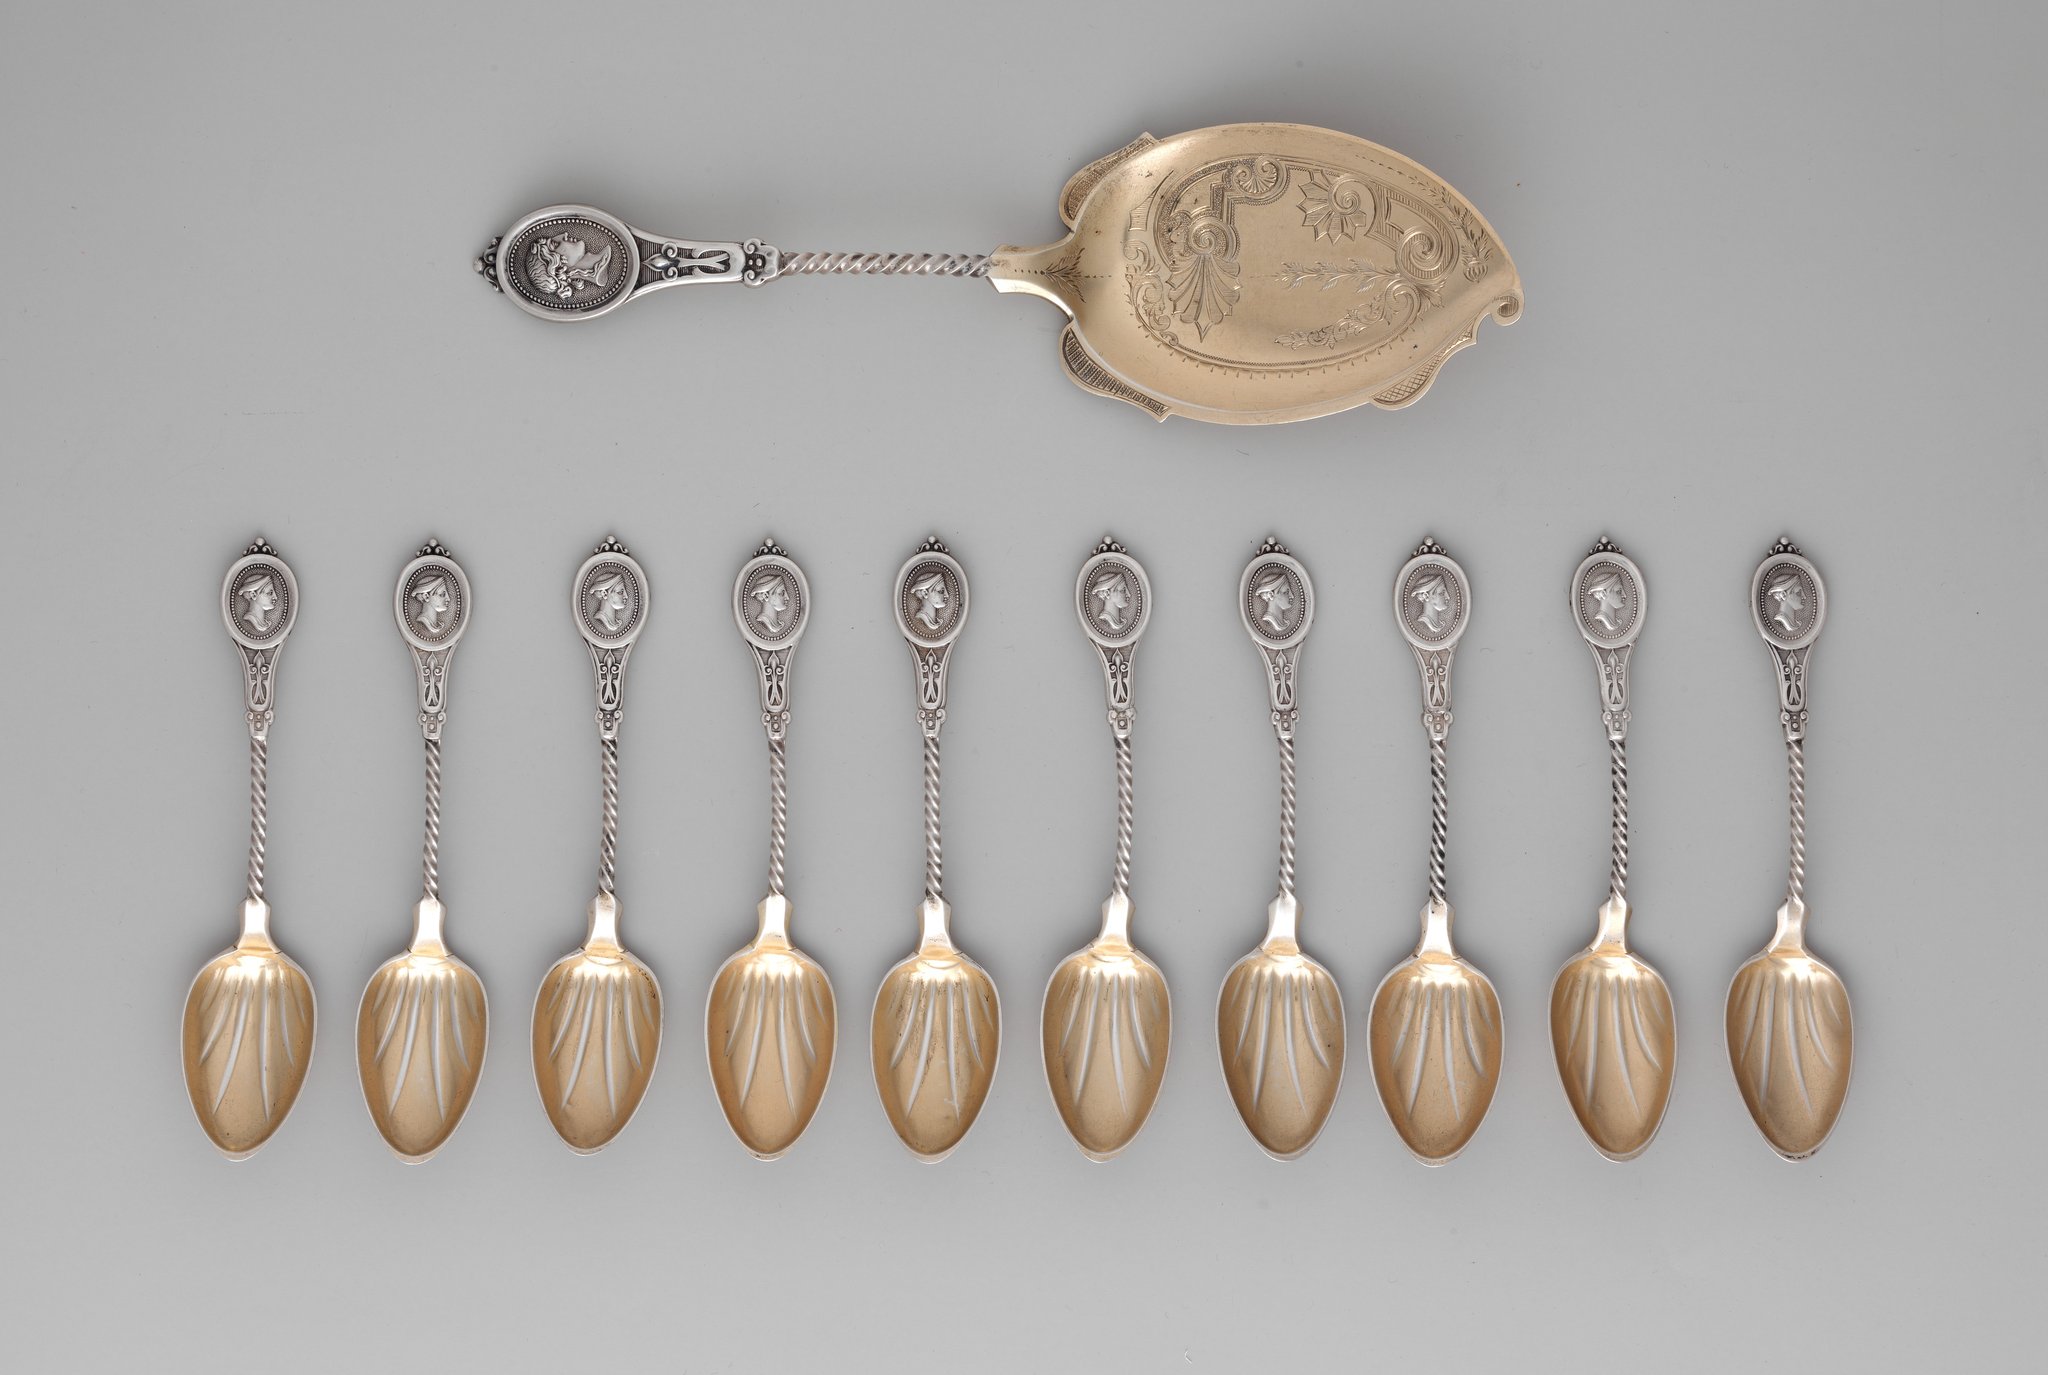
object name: ice cream slicer and spoon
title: Ice Cream Slicer and 10 Ice Cream Spoons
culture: american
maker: kidney, cann & johnson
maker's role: maker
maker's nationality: american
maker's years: 1863-1867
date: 1863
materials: silver, silver gilt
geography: united states